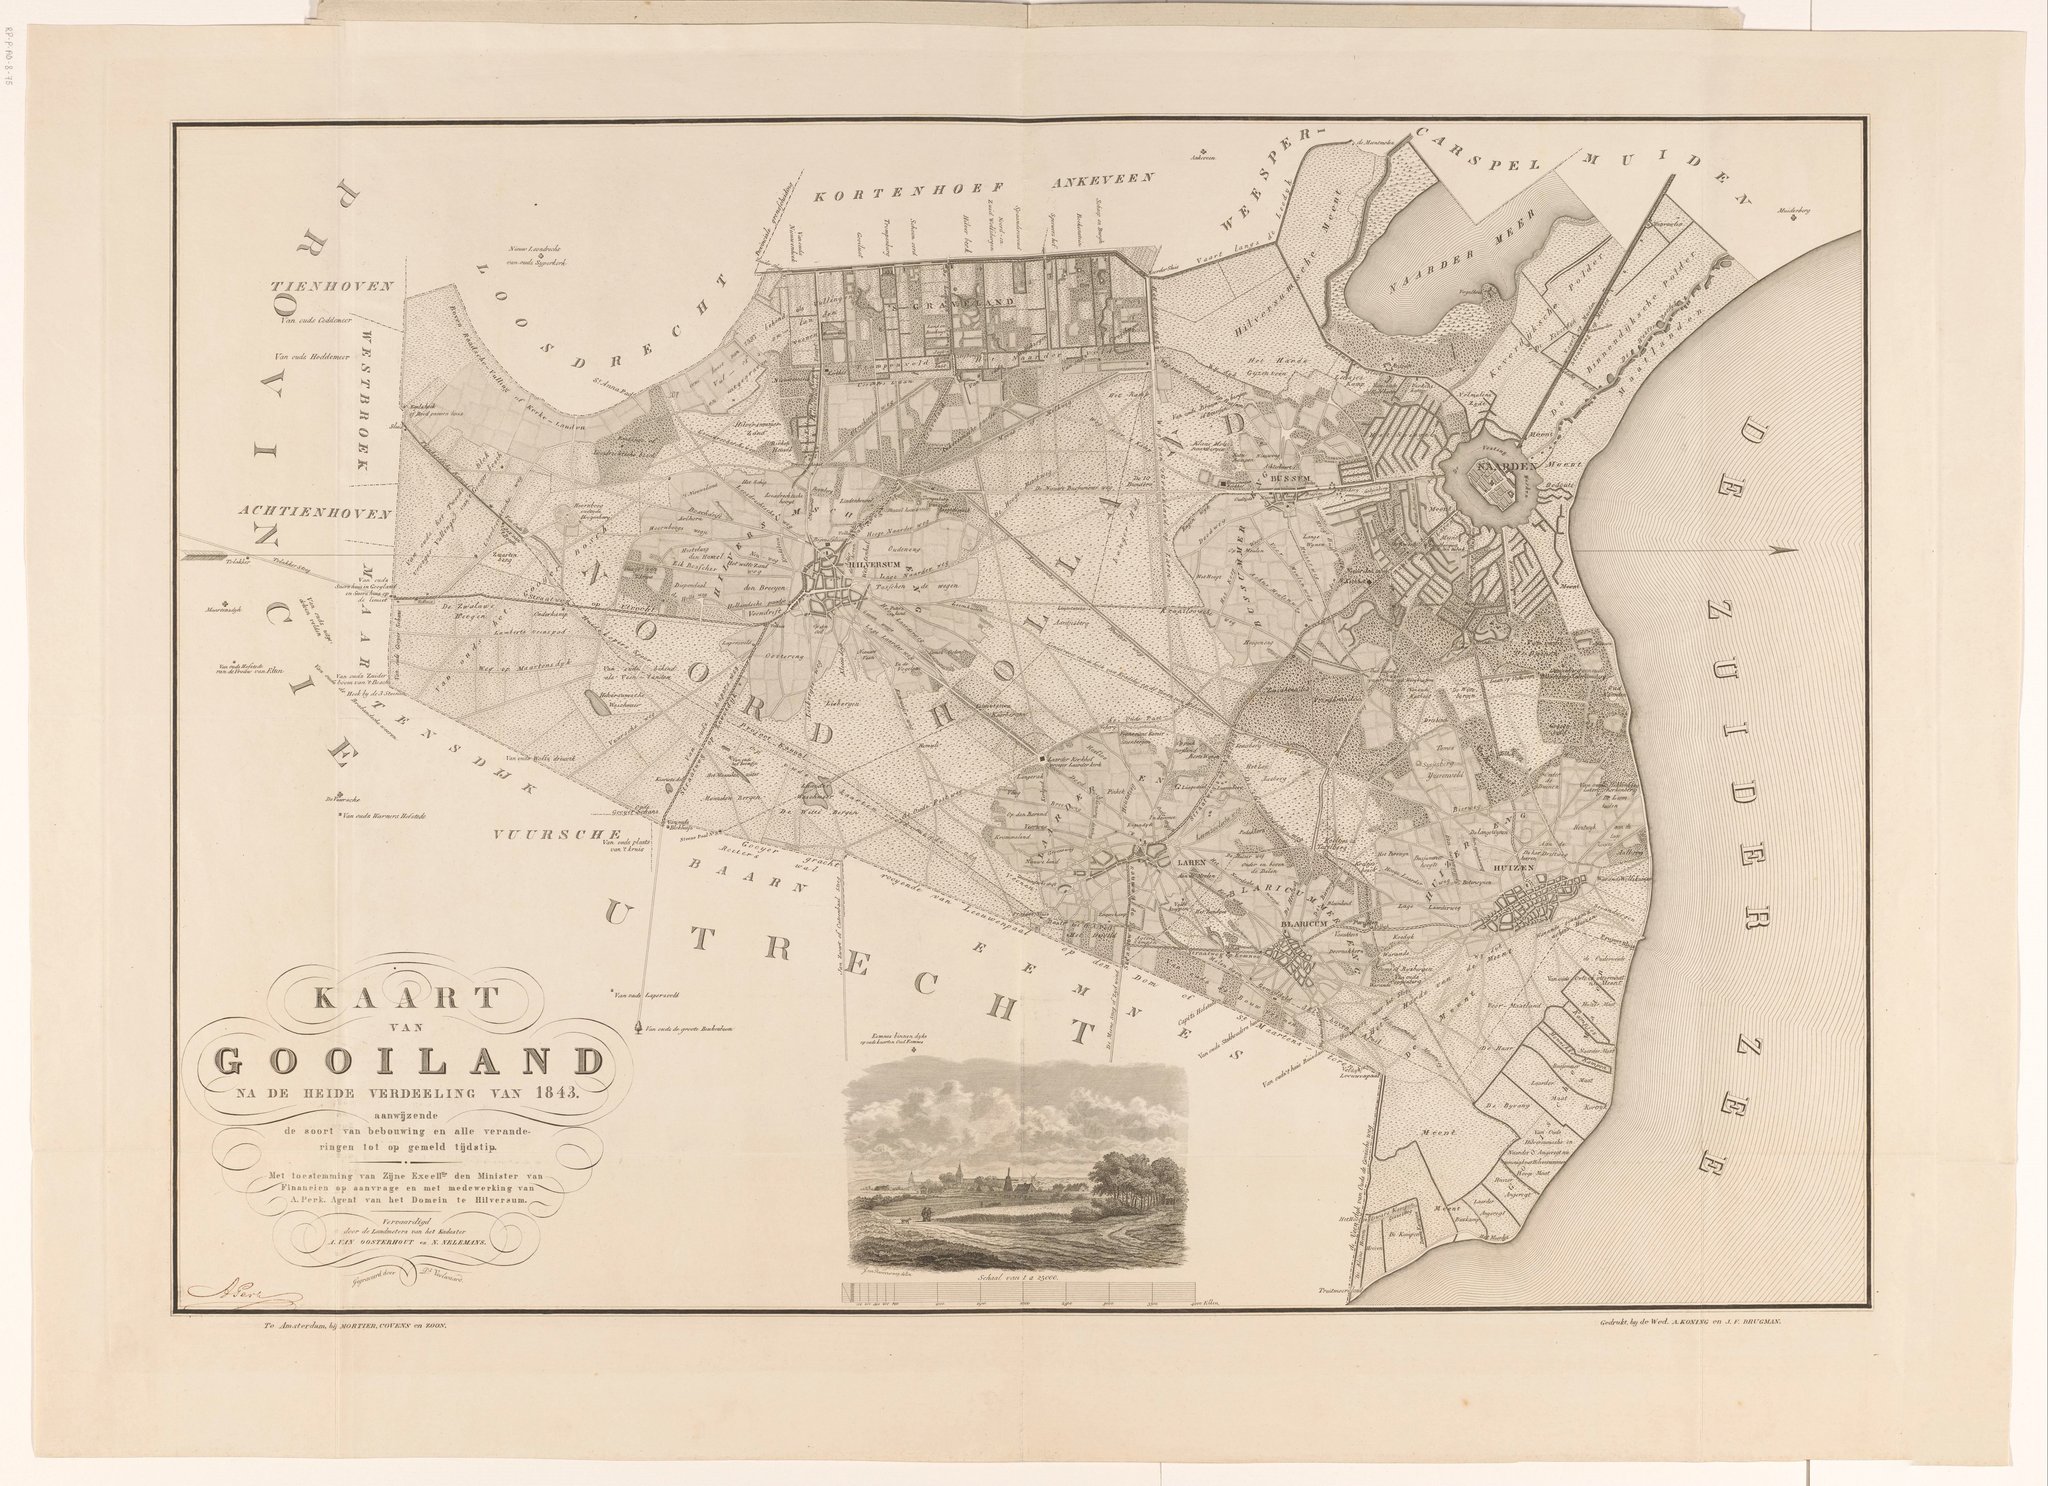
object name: print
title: Kaart van het Gooi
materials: ink, paper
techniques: engraving, etching, pen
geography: amsterdam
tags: landscapes, maps of separate countries or regions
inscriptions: inscription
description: Linksonder de titel. Onderaan in het midden een landschapsgezicht, daaronder een schaalstok: Schaal van 1 a 25000.